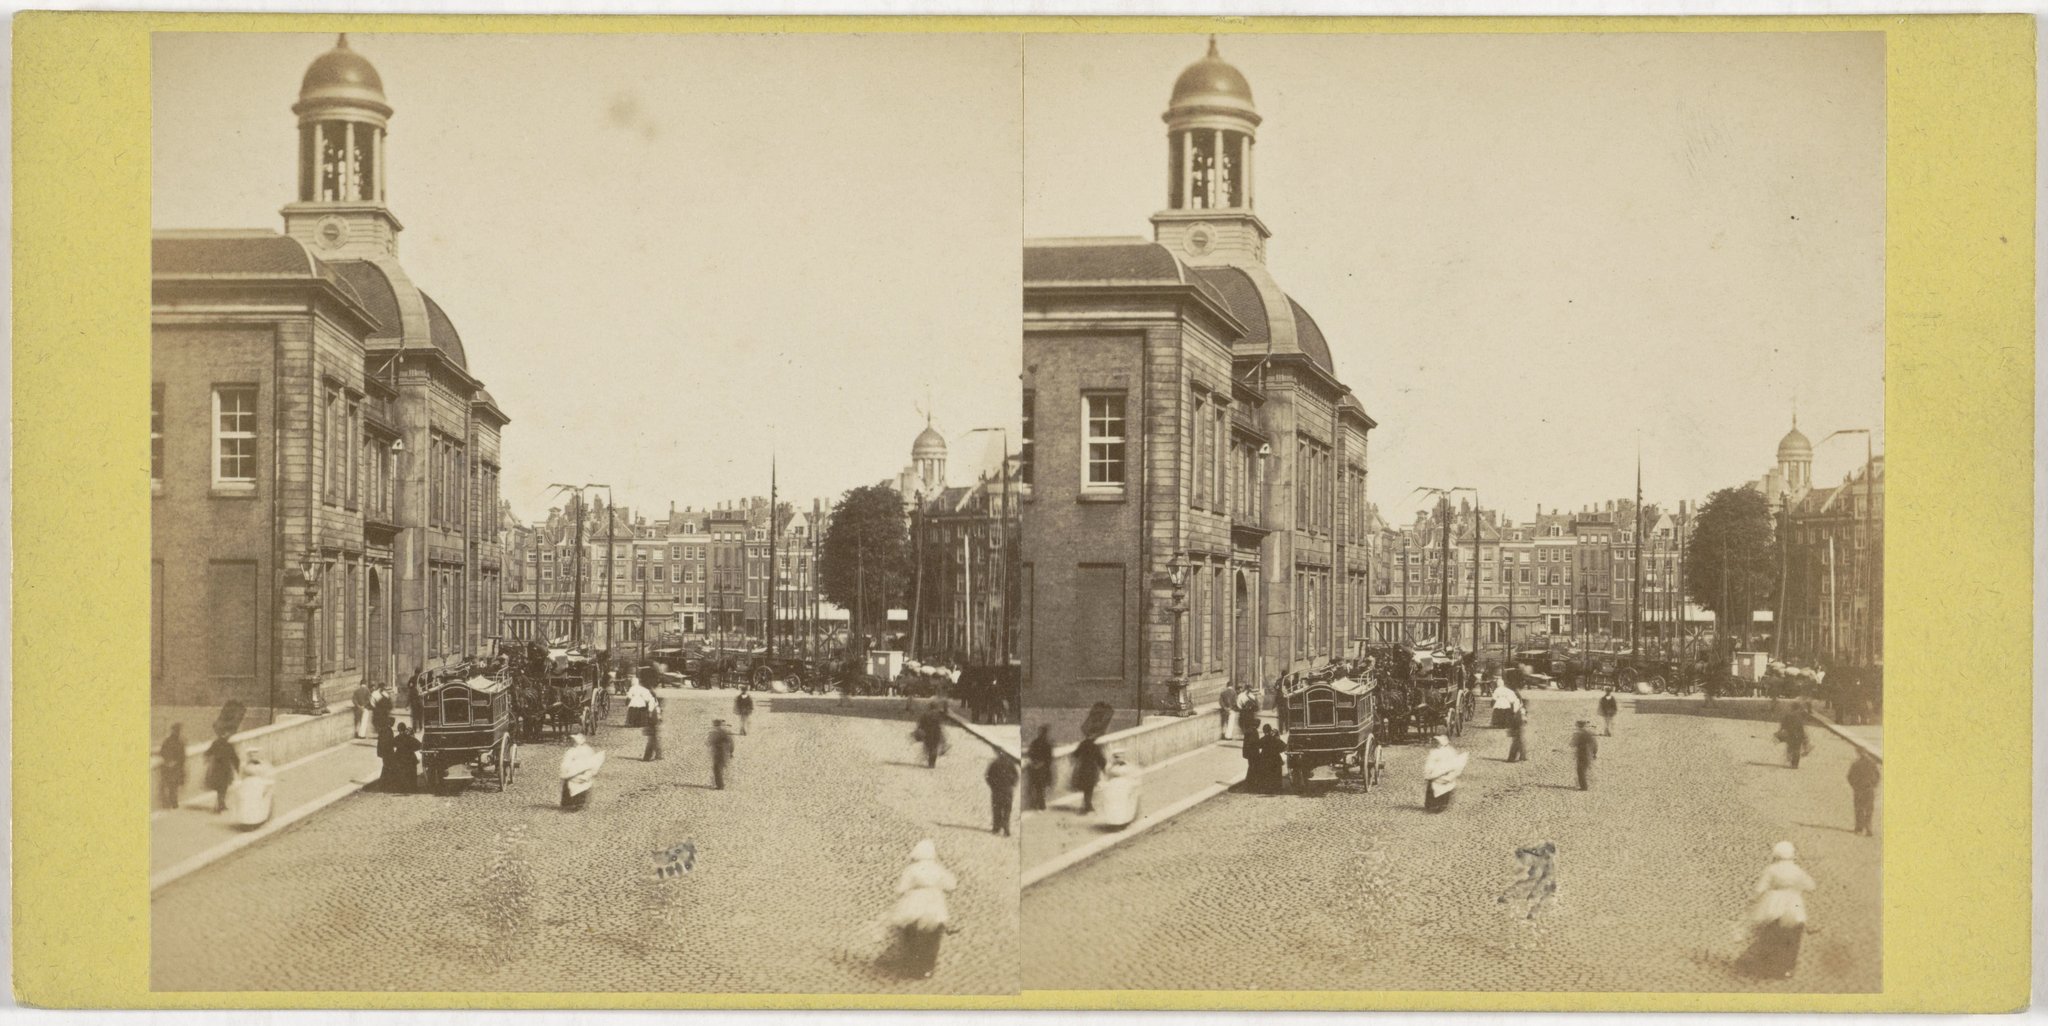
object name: stereograph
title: Gezicht op het beursgebouw van Rotterdam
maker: Anonymous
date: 1861-1870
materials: cardboard, paper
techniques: albumen print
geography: rotterdam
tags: street, exchange, bourse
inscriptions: inscription: ‘1.50’, inscription: ‘No. 74’